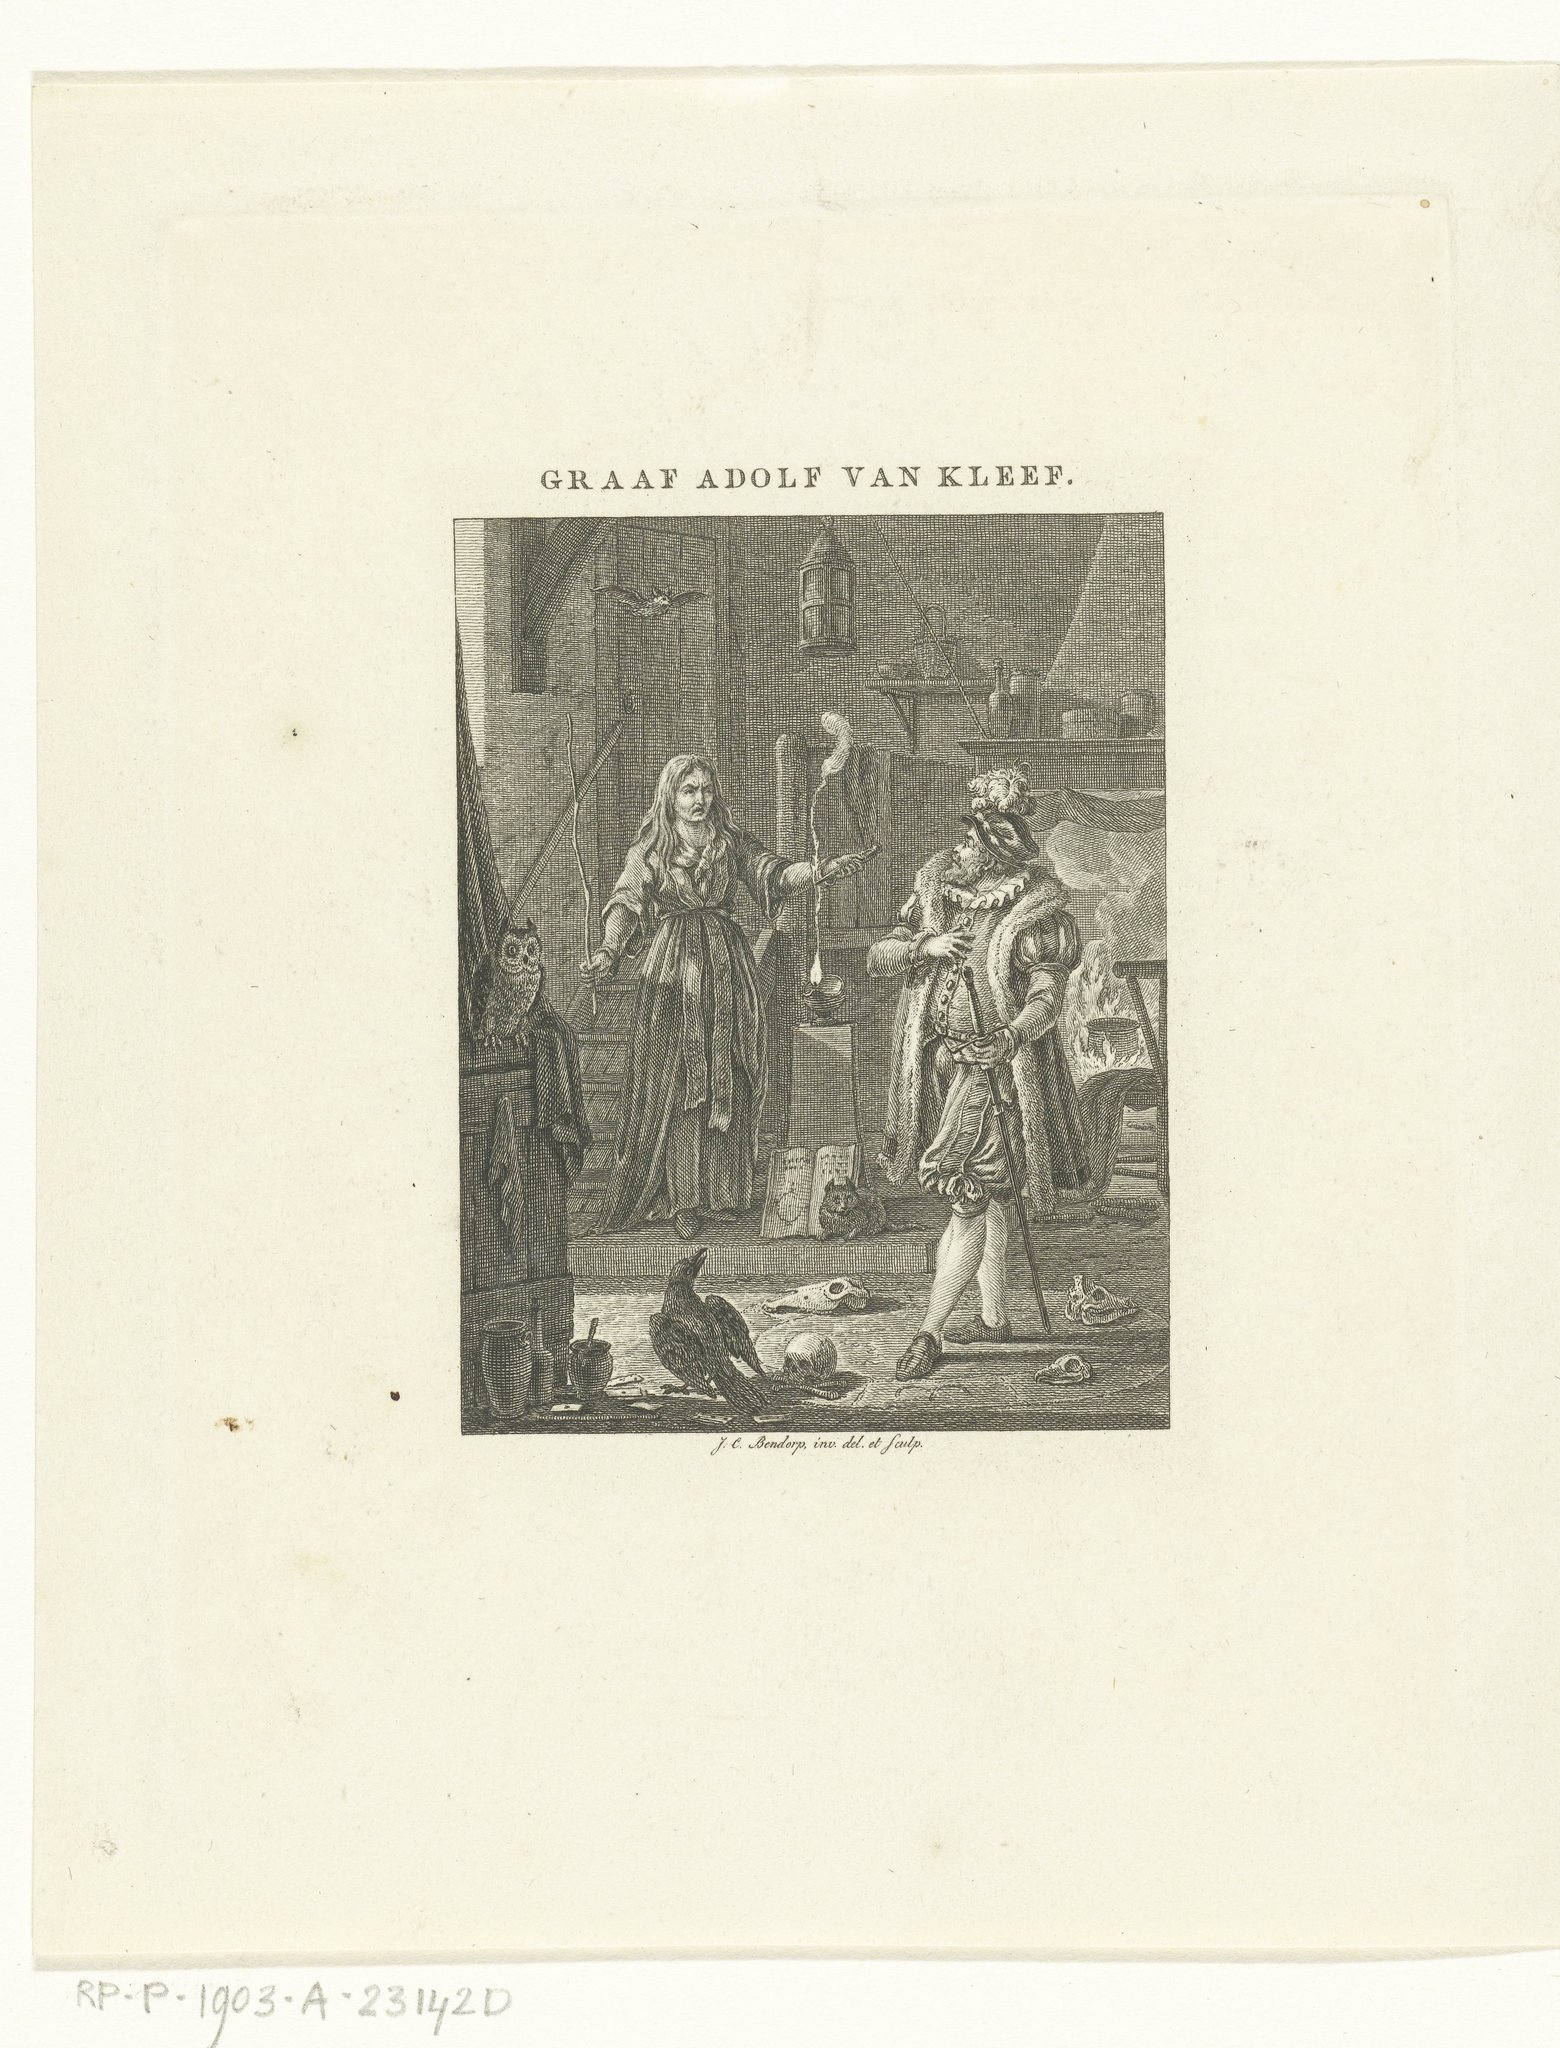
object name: book illustration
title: Graaf Adolf van Kleef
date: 1776-1847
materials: paper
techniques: etching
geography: netherlands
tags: witch(es), sorcerer(s) at work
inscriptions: collector's mark: Lugt 2228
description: Interieur met graaf Adolf van Kleef die het doelwit is van de bezwering van een heks. In de ruimte verwijzen verschillende attributen naar de praktijken van de heks, op de grond liggen dierenschedels in een cirkel en in het midden heeft de graaf zijn positie genomen. Verder zijn een vleermuis, kat, uil en raaf aanwezig.